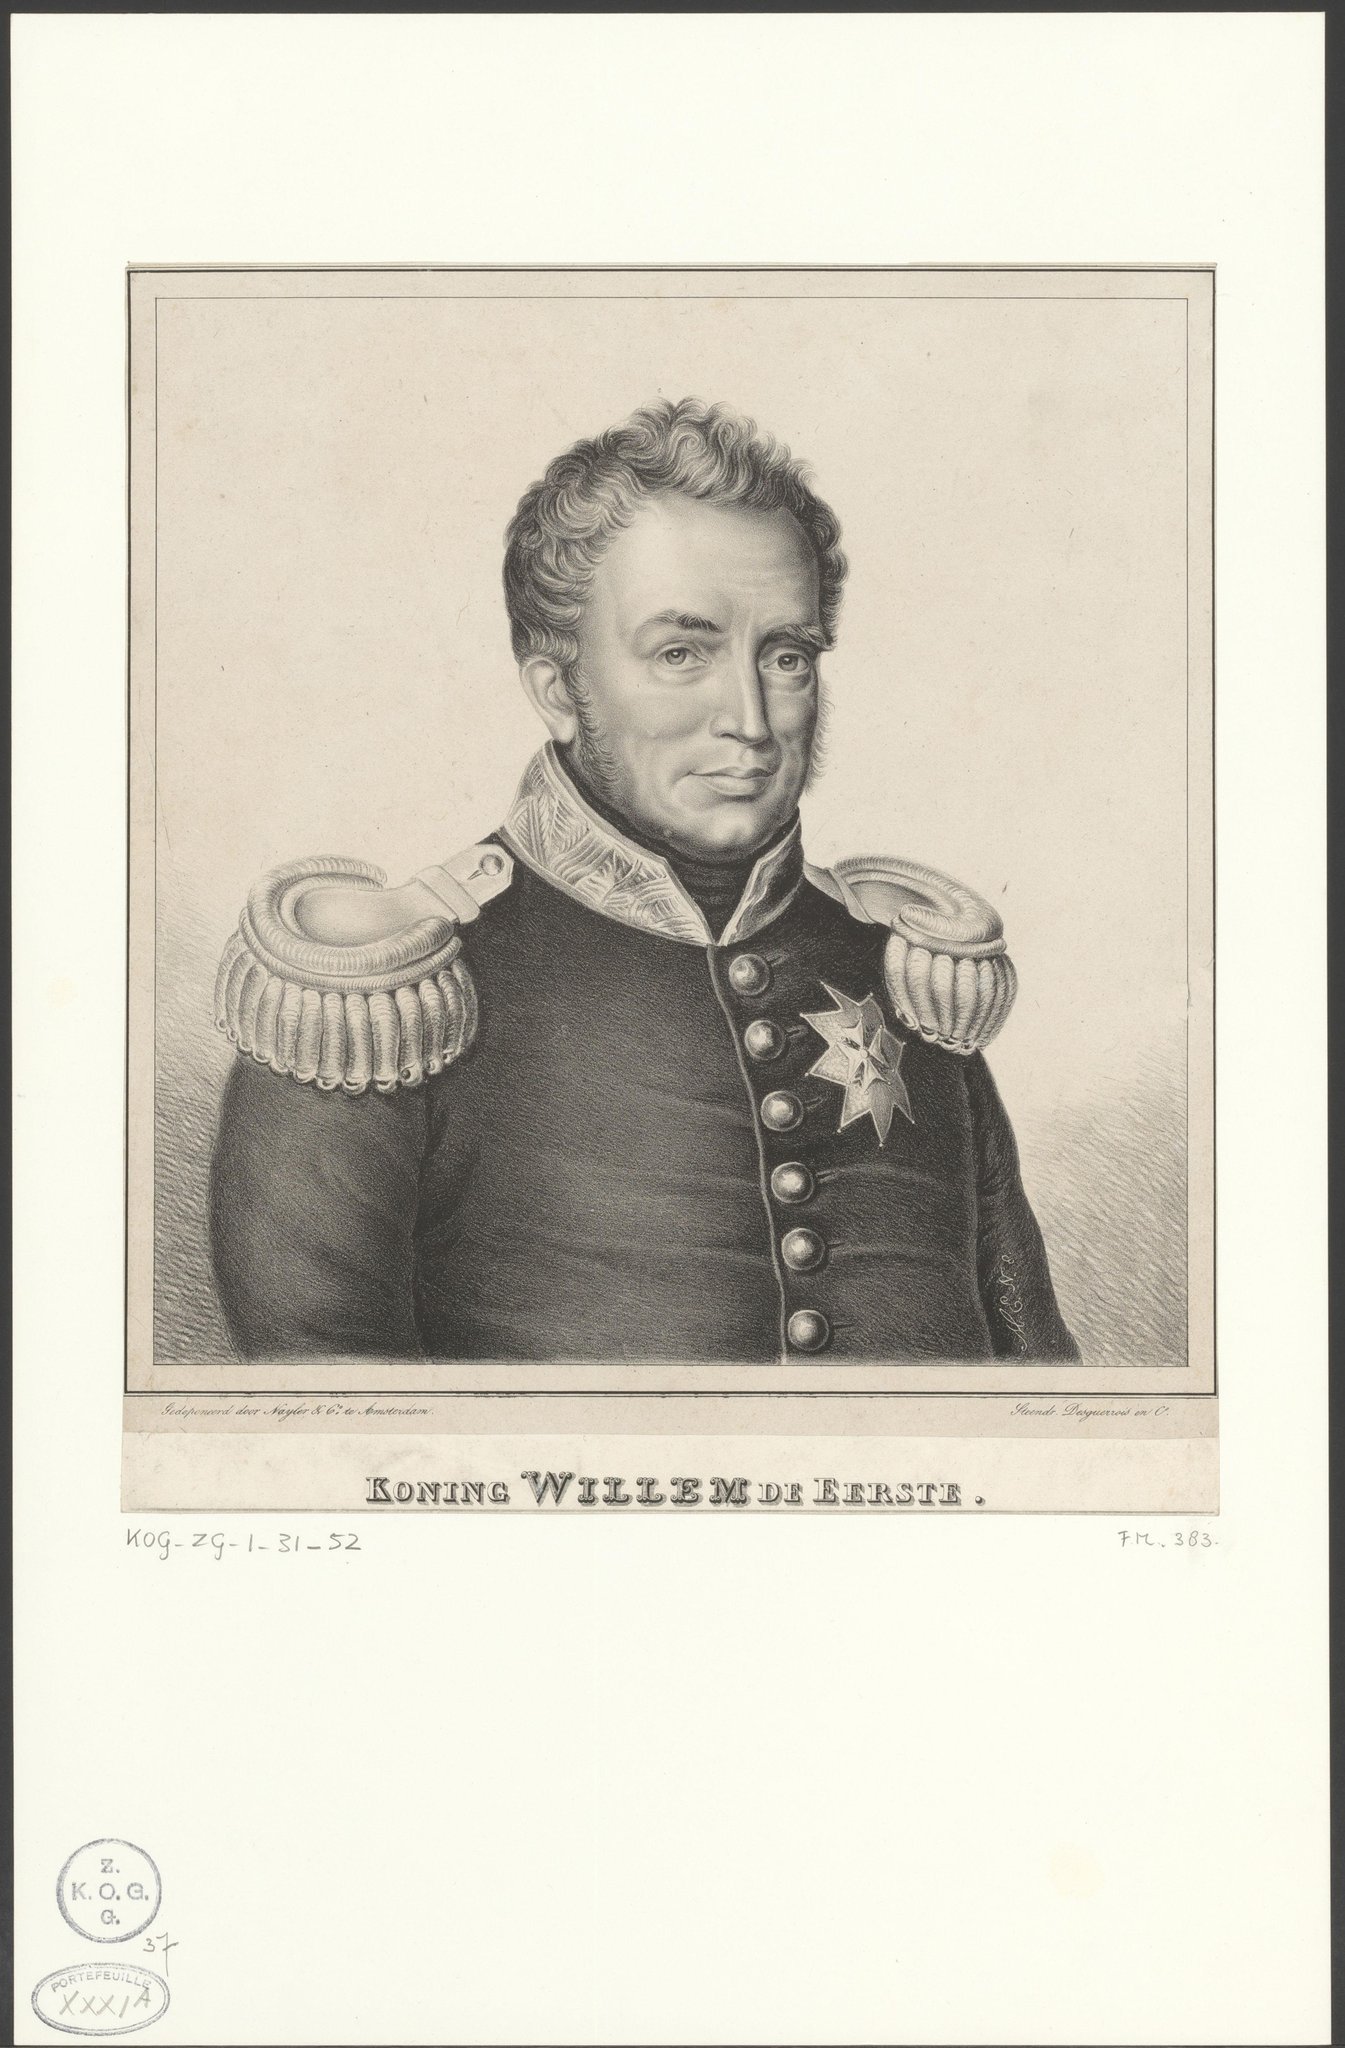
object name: print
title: Portret van Willem I, koning der Nederlanden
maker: maria elisabeth liernur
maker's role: print maker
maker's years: 1802-1874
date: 1831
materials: paper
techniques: lithograph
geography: amsterdam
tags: the hague, berlin, william i of the netherlands, historical persons, king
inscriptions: stamp, : ‘Gedeponeerd door Nayler & Co. te Amsterdam’, collector's mark: Lugt 1641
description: Onderwerpsrubrieken binnen de Atlas Zeden en Gewoonten: Portretten, Portretten van Vorsten uit het huis van Oranje, Regeerende Vorsten, Koningen uit het huis van Oranje.